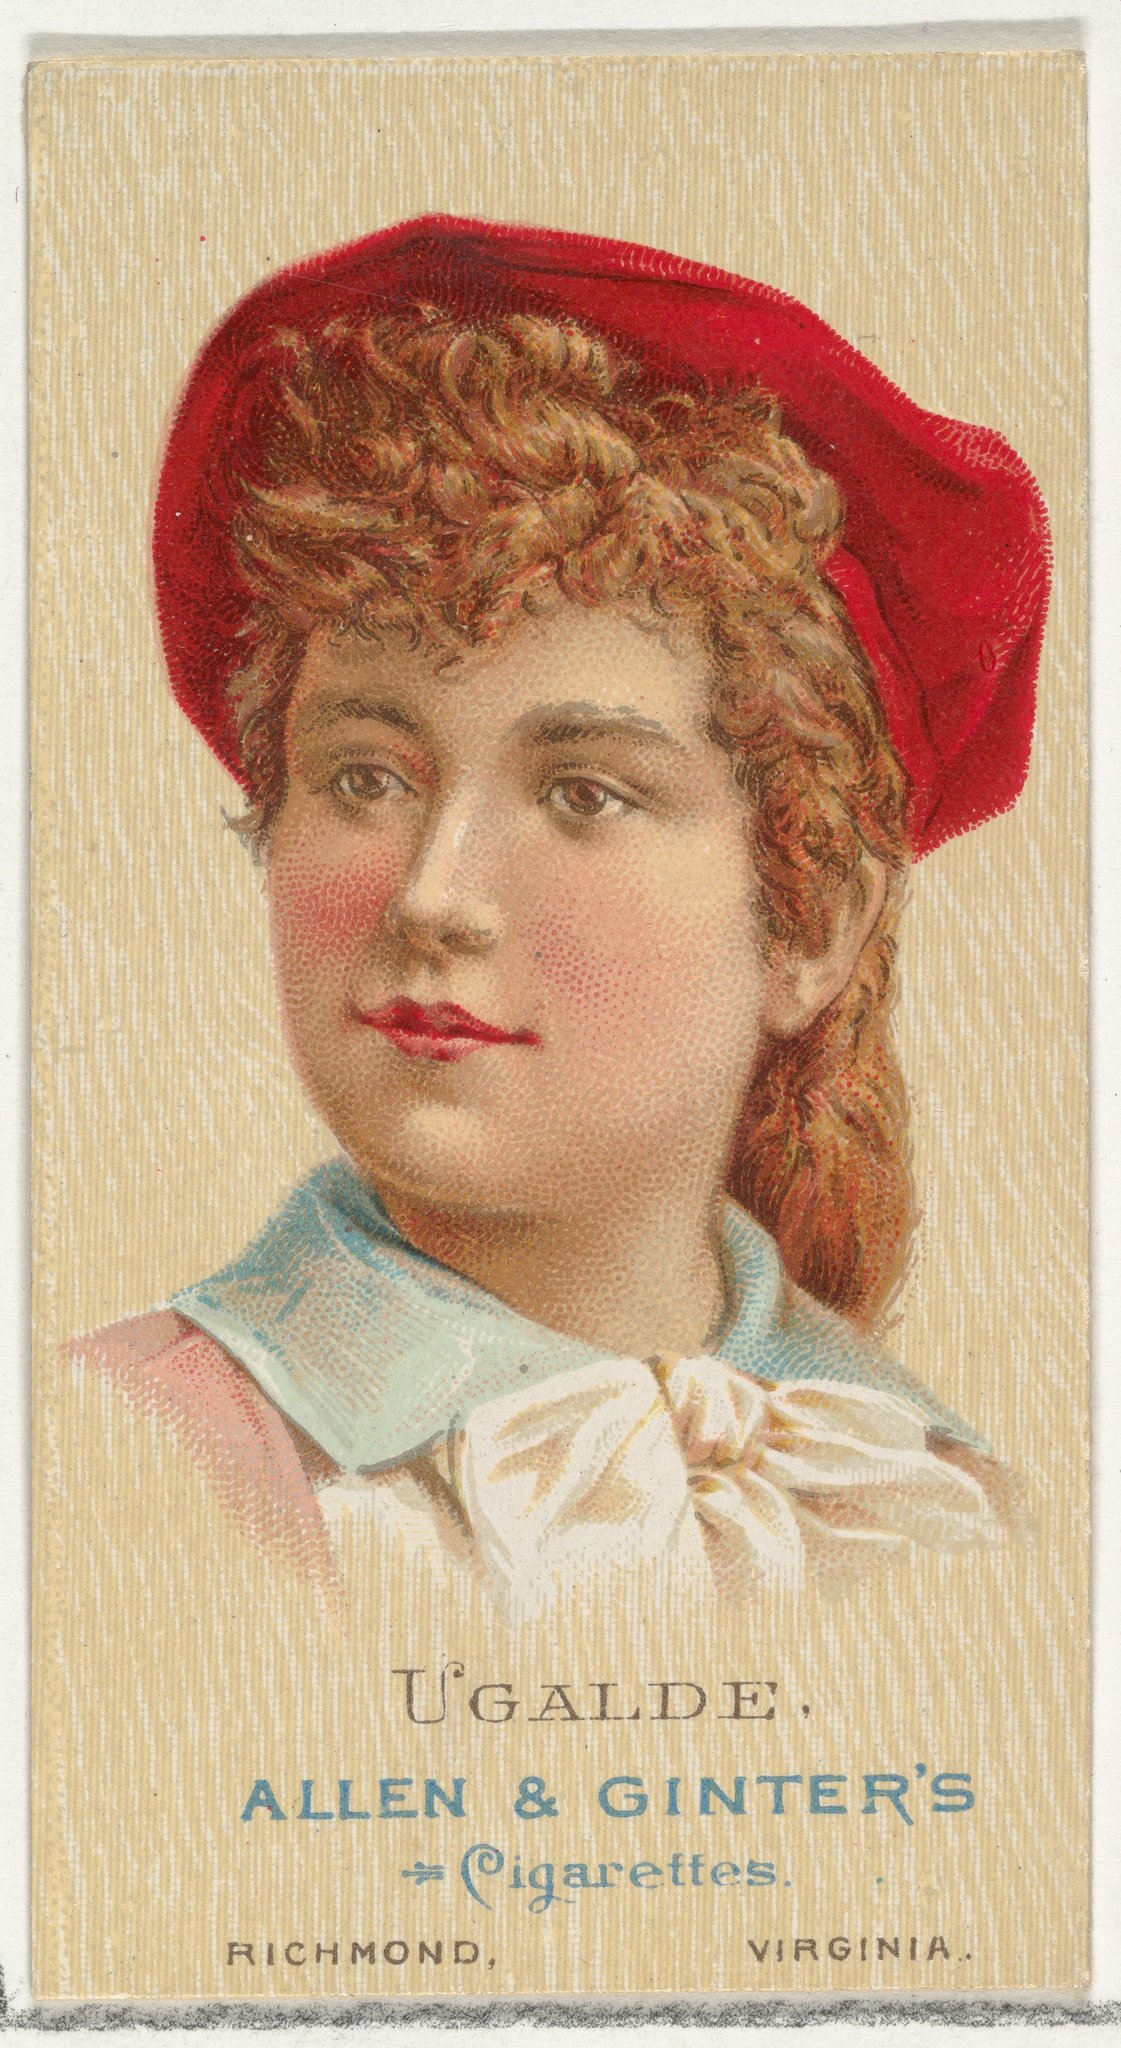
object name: print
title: Ugalde, from World's Beauties, Series 2 (N27) for Allen & Ginter Cigarettes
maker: allen & ginter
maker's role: publisher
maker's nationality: american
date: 1888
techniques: color lithograph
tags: women